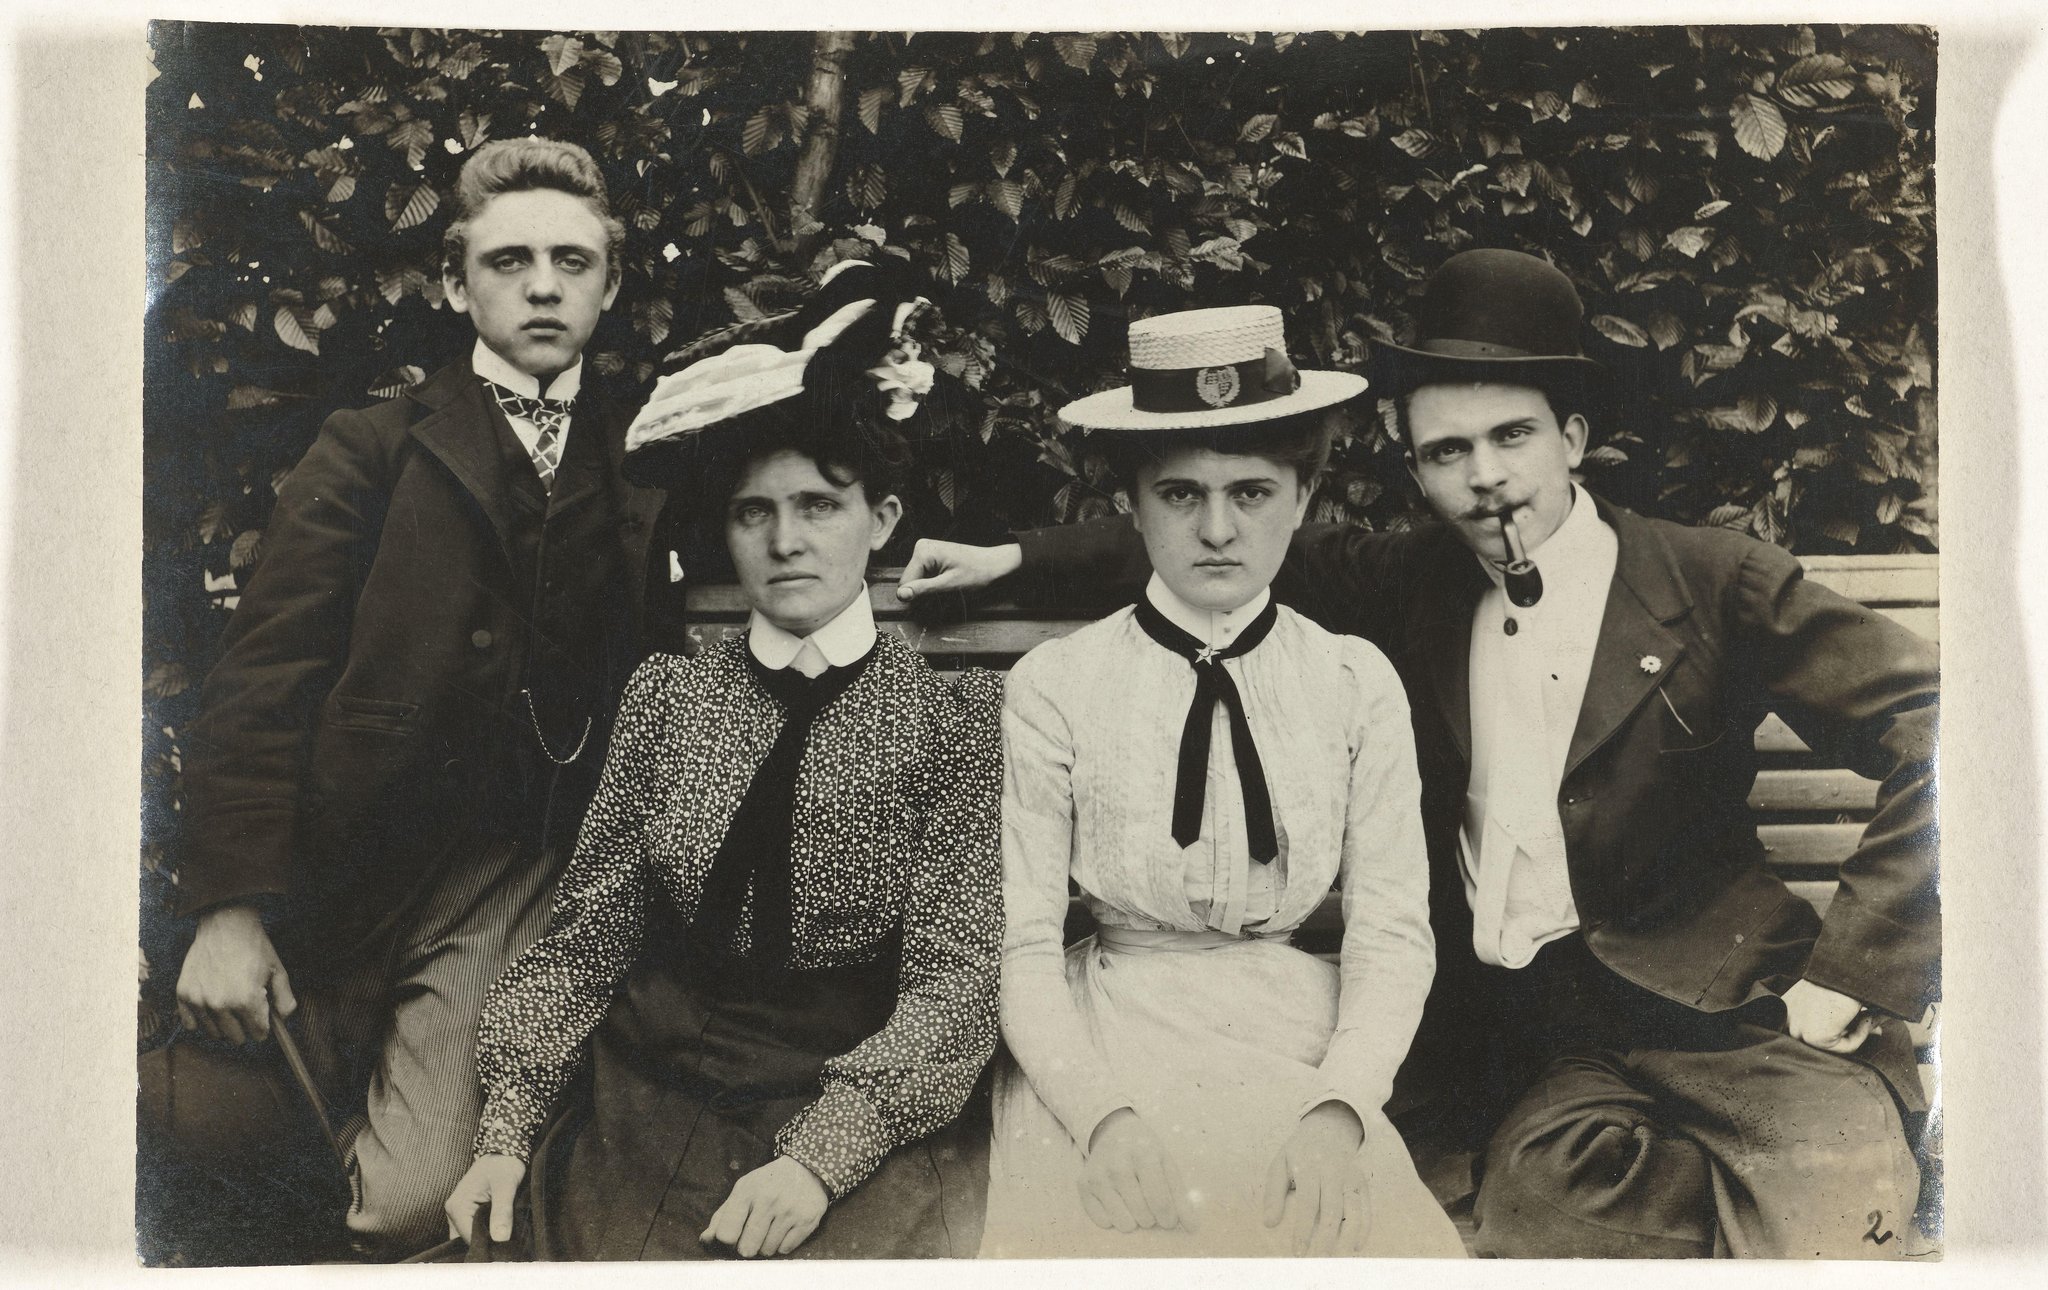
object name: photograph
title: Groepsfoto van een onbekend gezelschap, vermoedelijk Frans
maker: Anonymous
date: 1900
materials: paper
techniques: gelatin silver print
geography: france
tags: anonymous historical persons portrayed in a group, in a group-portrait, france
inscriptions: inscription: ‘1900./ 22 ans’